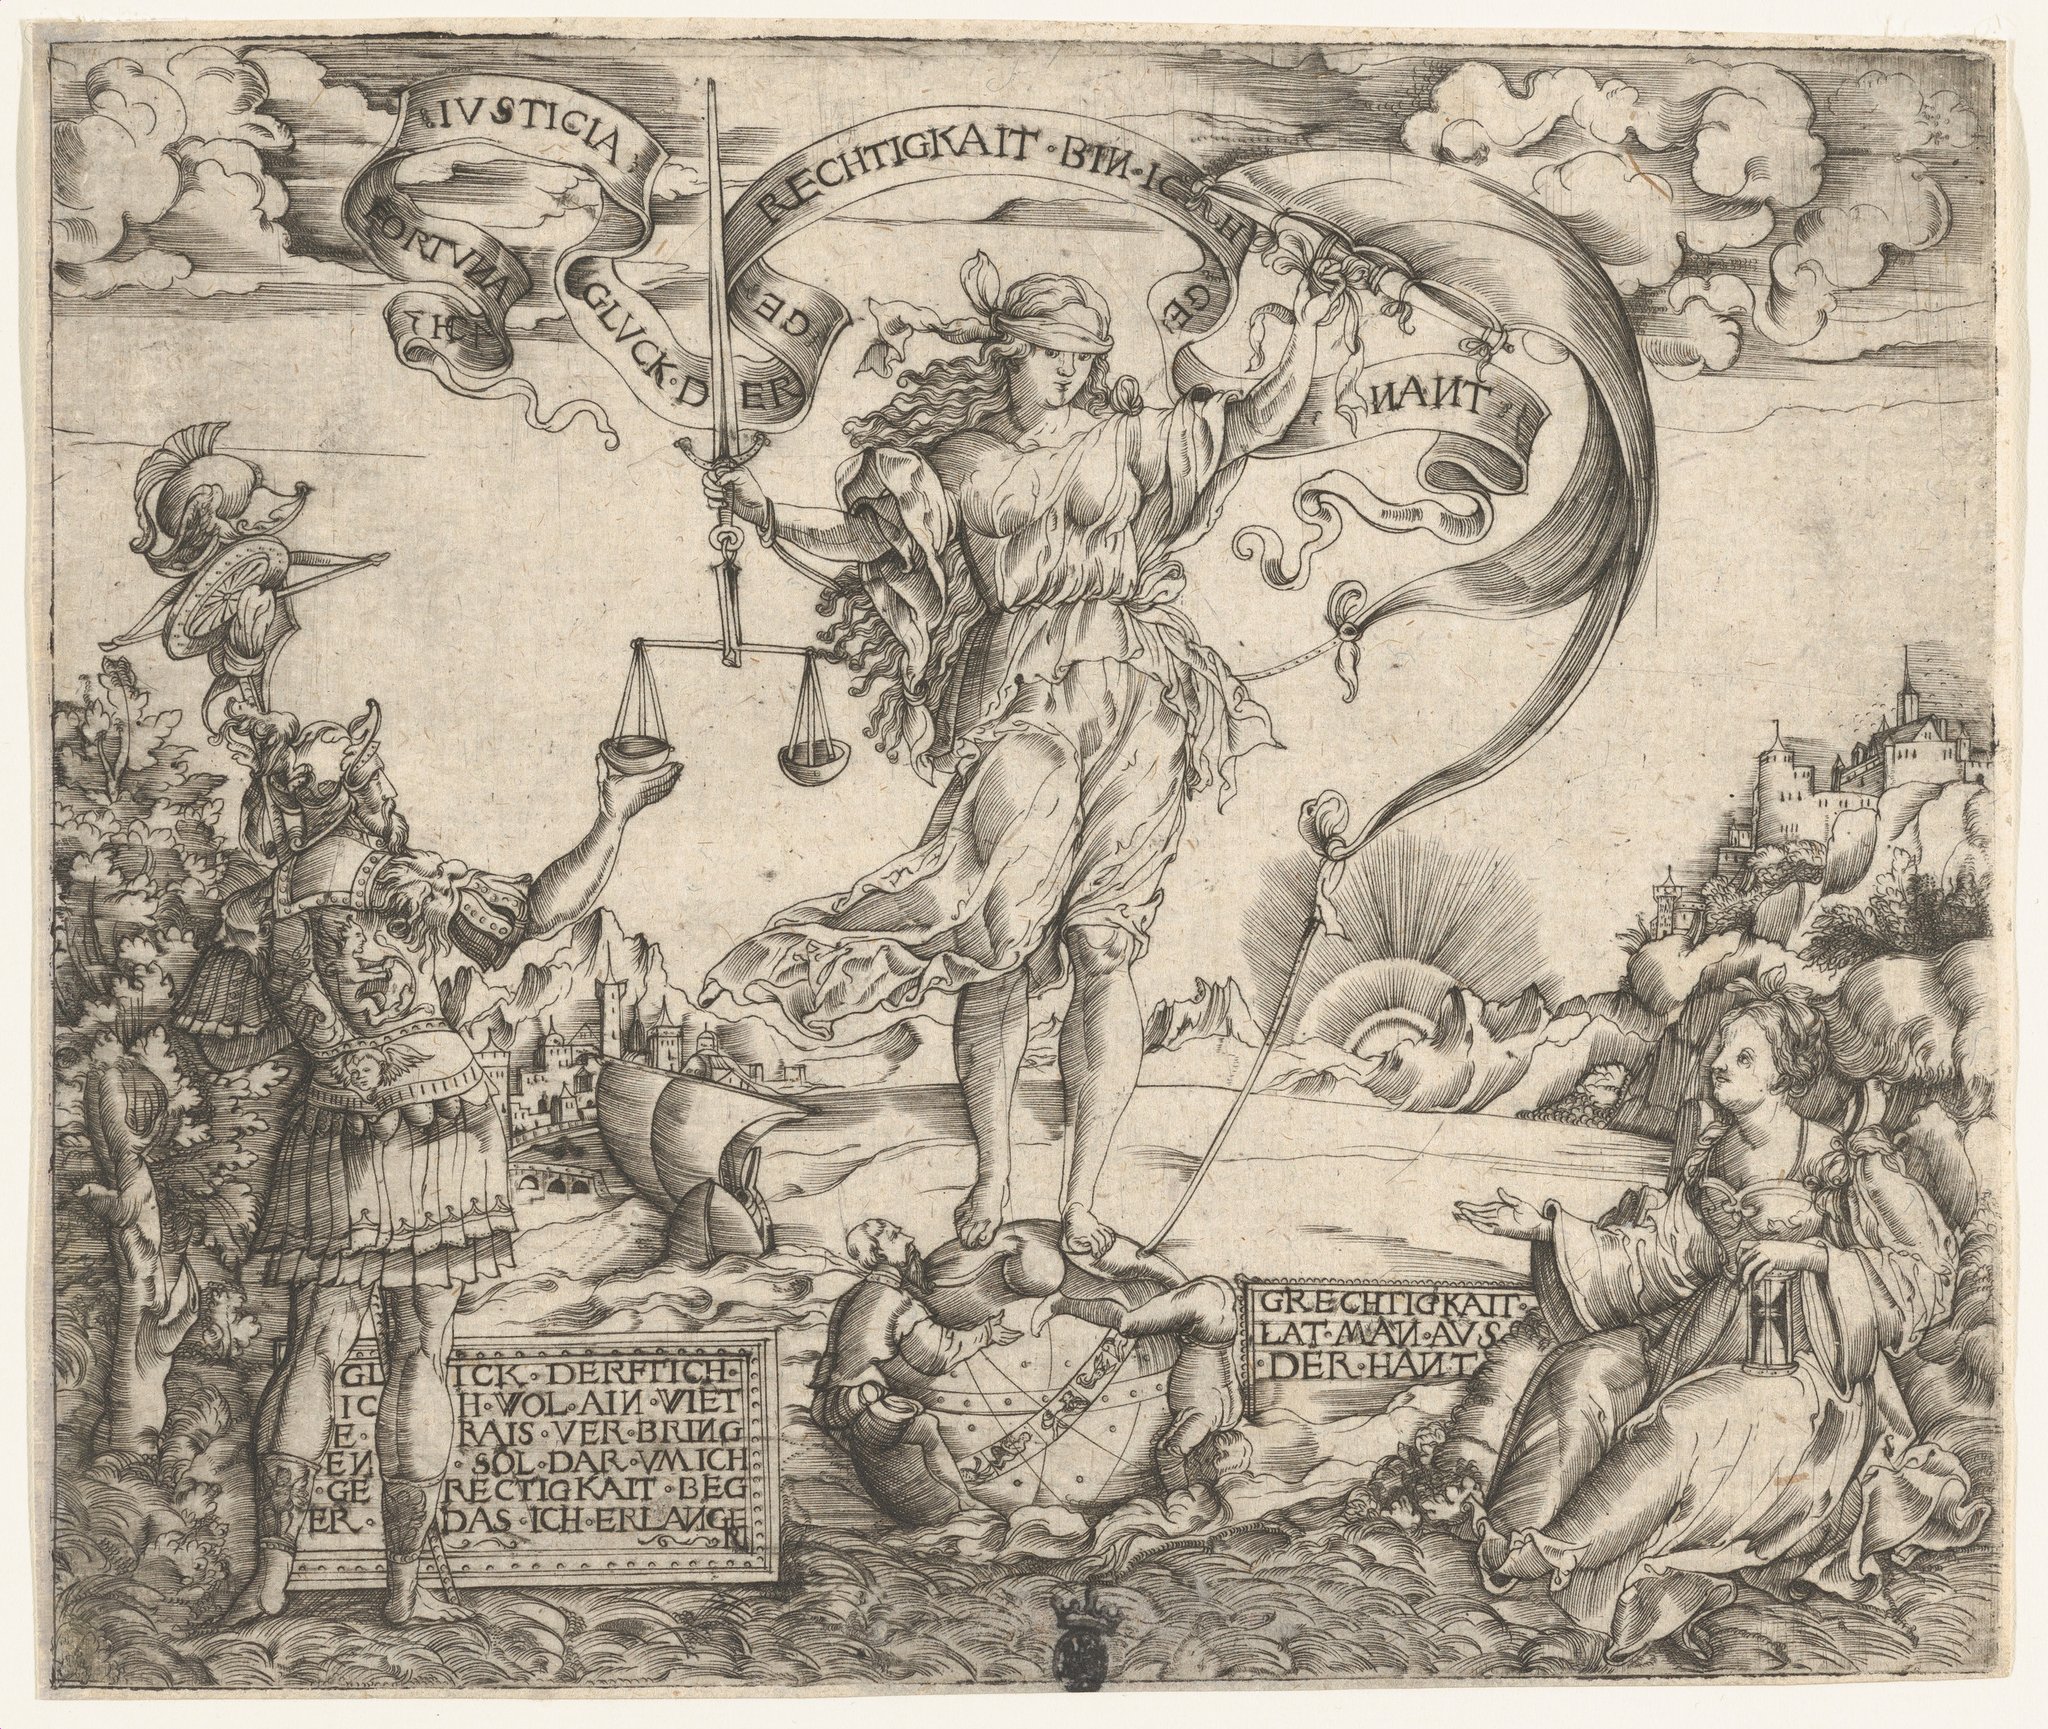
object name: print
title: Allegory of Fortuna and Justice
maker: monogrammist hc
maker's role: artist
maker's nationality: german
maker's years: 1534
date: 1534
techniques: engraving, etching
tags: men,women,scales